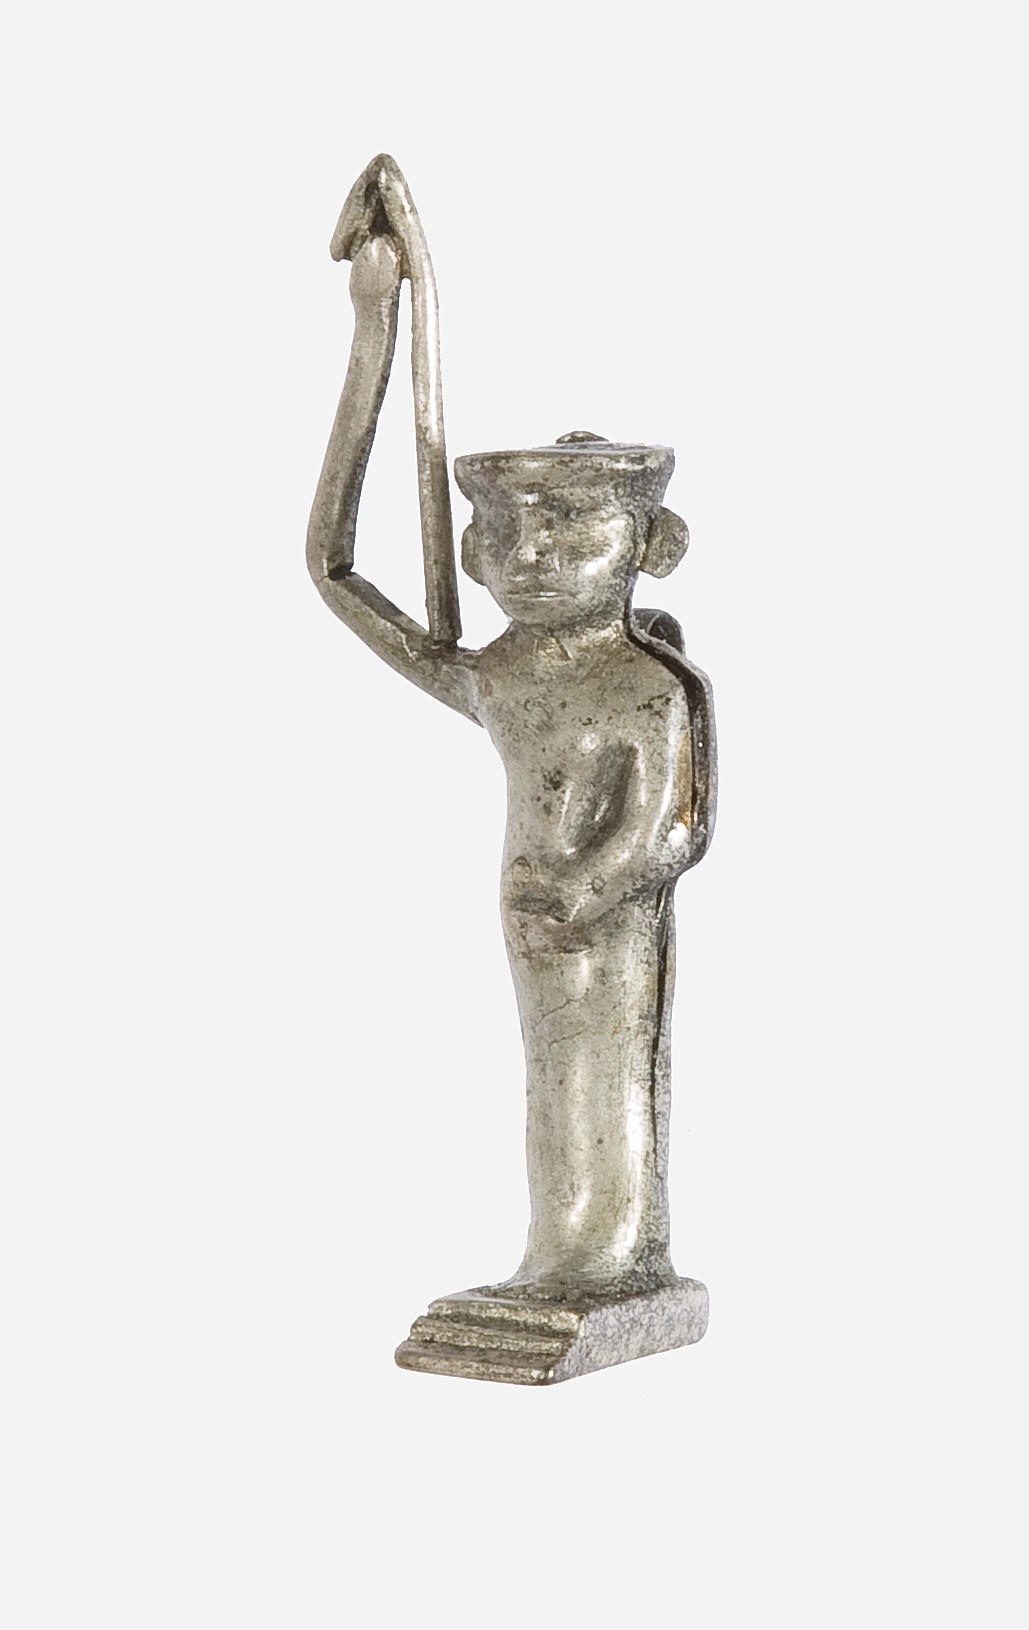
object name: amulet, min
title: Amulet Depicting the God Min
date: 1850-1775 BCE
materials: silver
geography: egypt